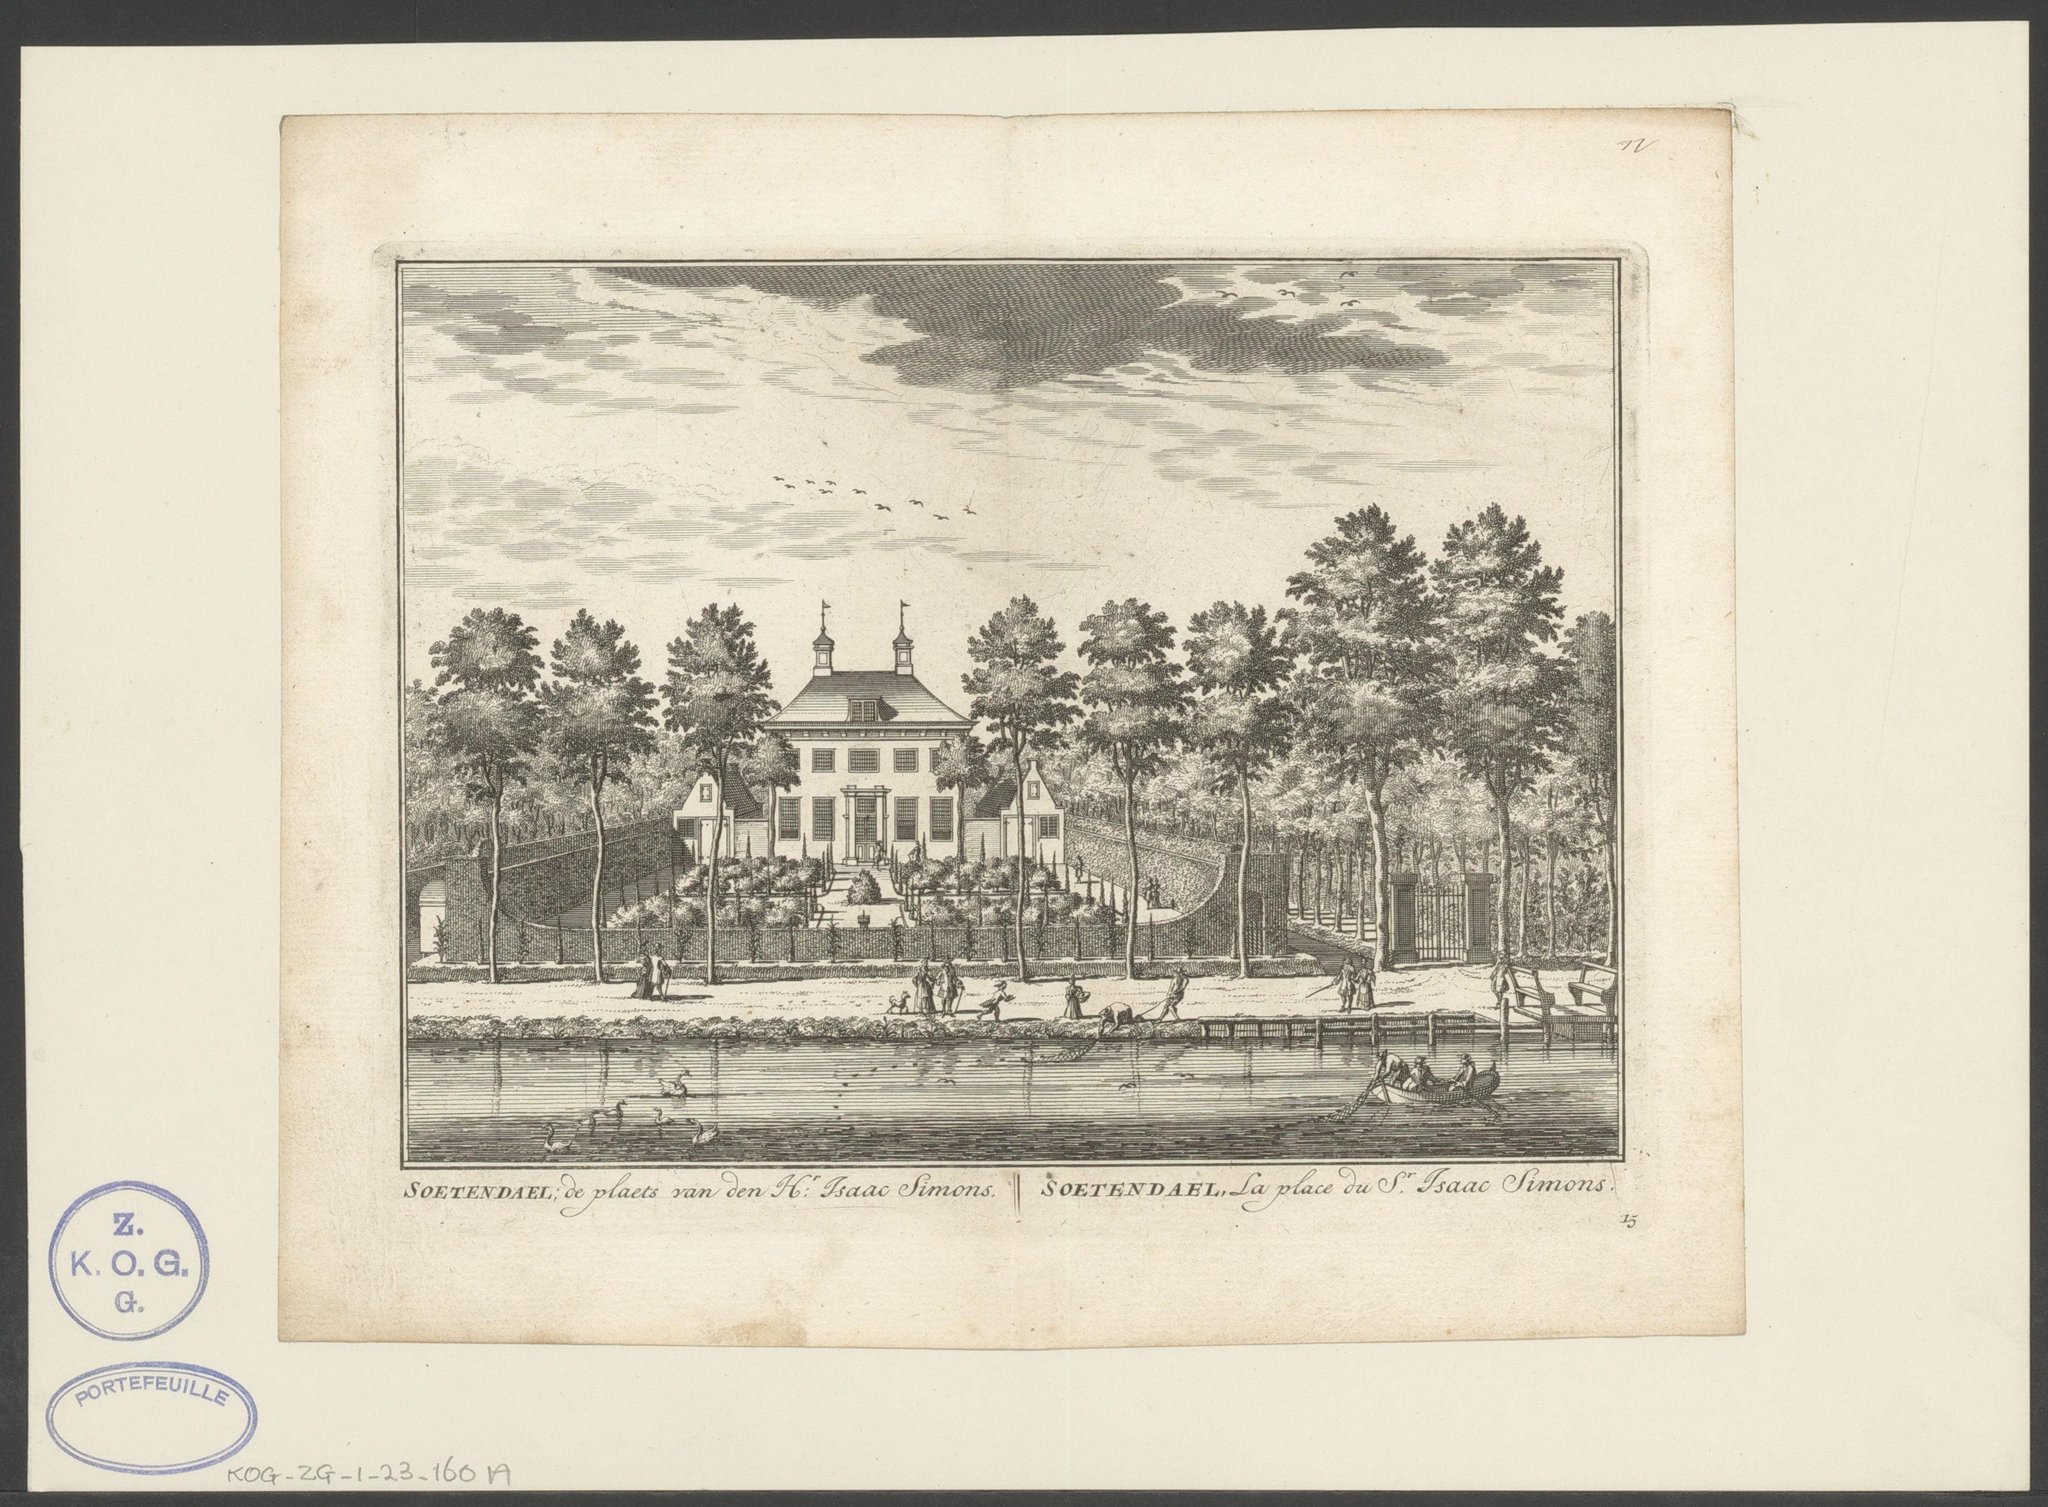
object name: print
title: Gezicht op buitenplaats Soetendael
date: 1719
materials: paper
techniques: engraving, etching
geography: amsterdam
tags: river, rural housing, e.g. country-house, villa, cottage, french or architectonic garden; formal garden, maarssen, vecht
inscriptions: stamp, collector's mark: Lugt 1641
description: Prent uit: De zegepraalende Vecht, vertoonende verscheidene gesichten van lustplaatsen, heeren huysen en dorpen, beginnende van Uitrecht en met Muyden besluytende. Amsterdam: Wed. Nicolaes Visscher, 1719.